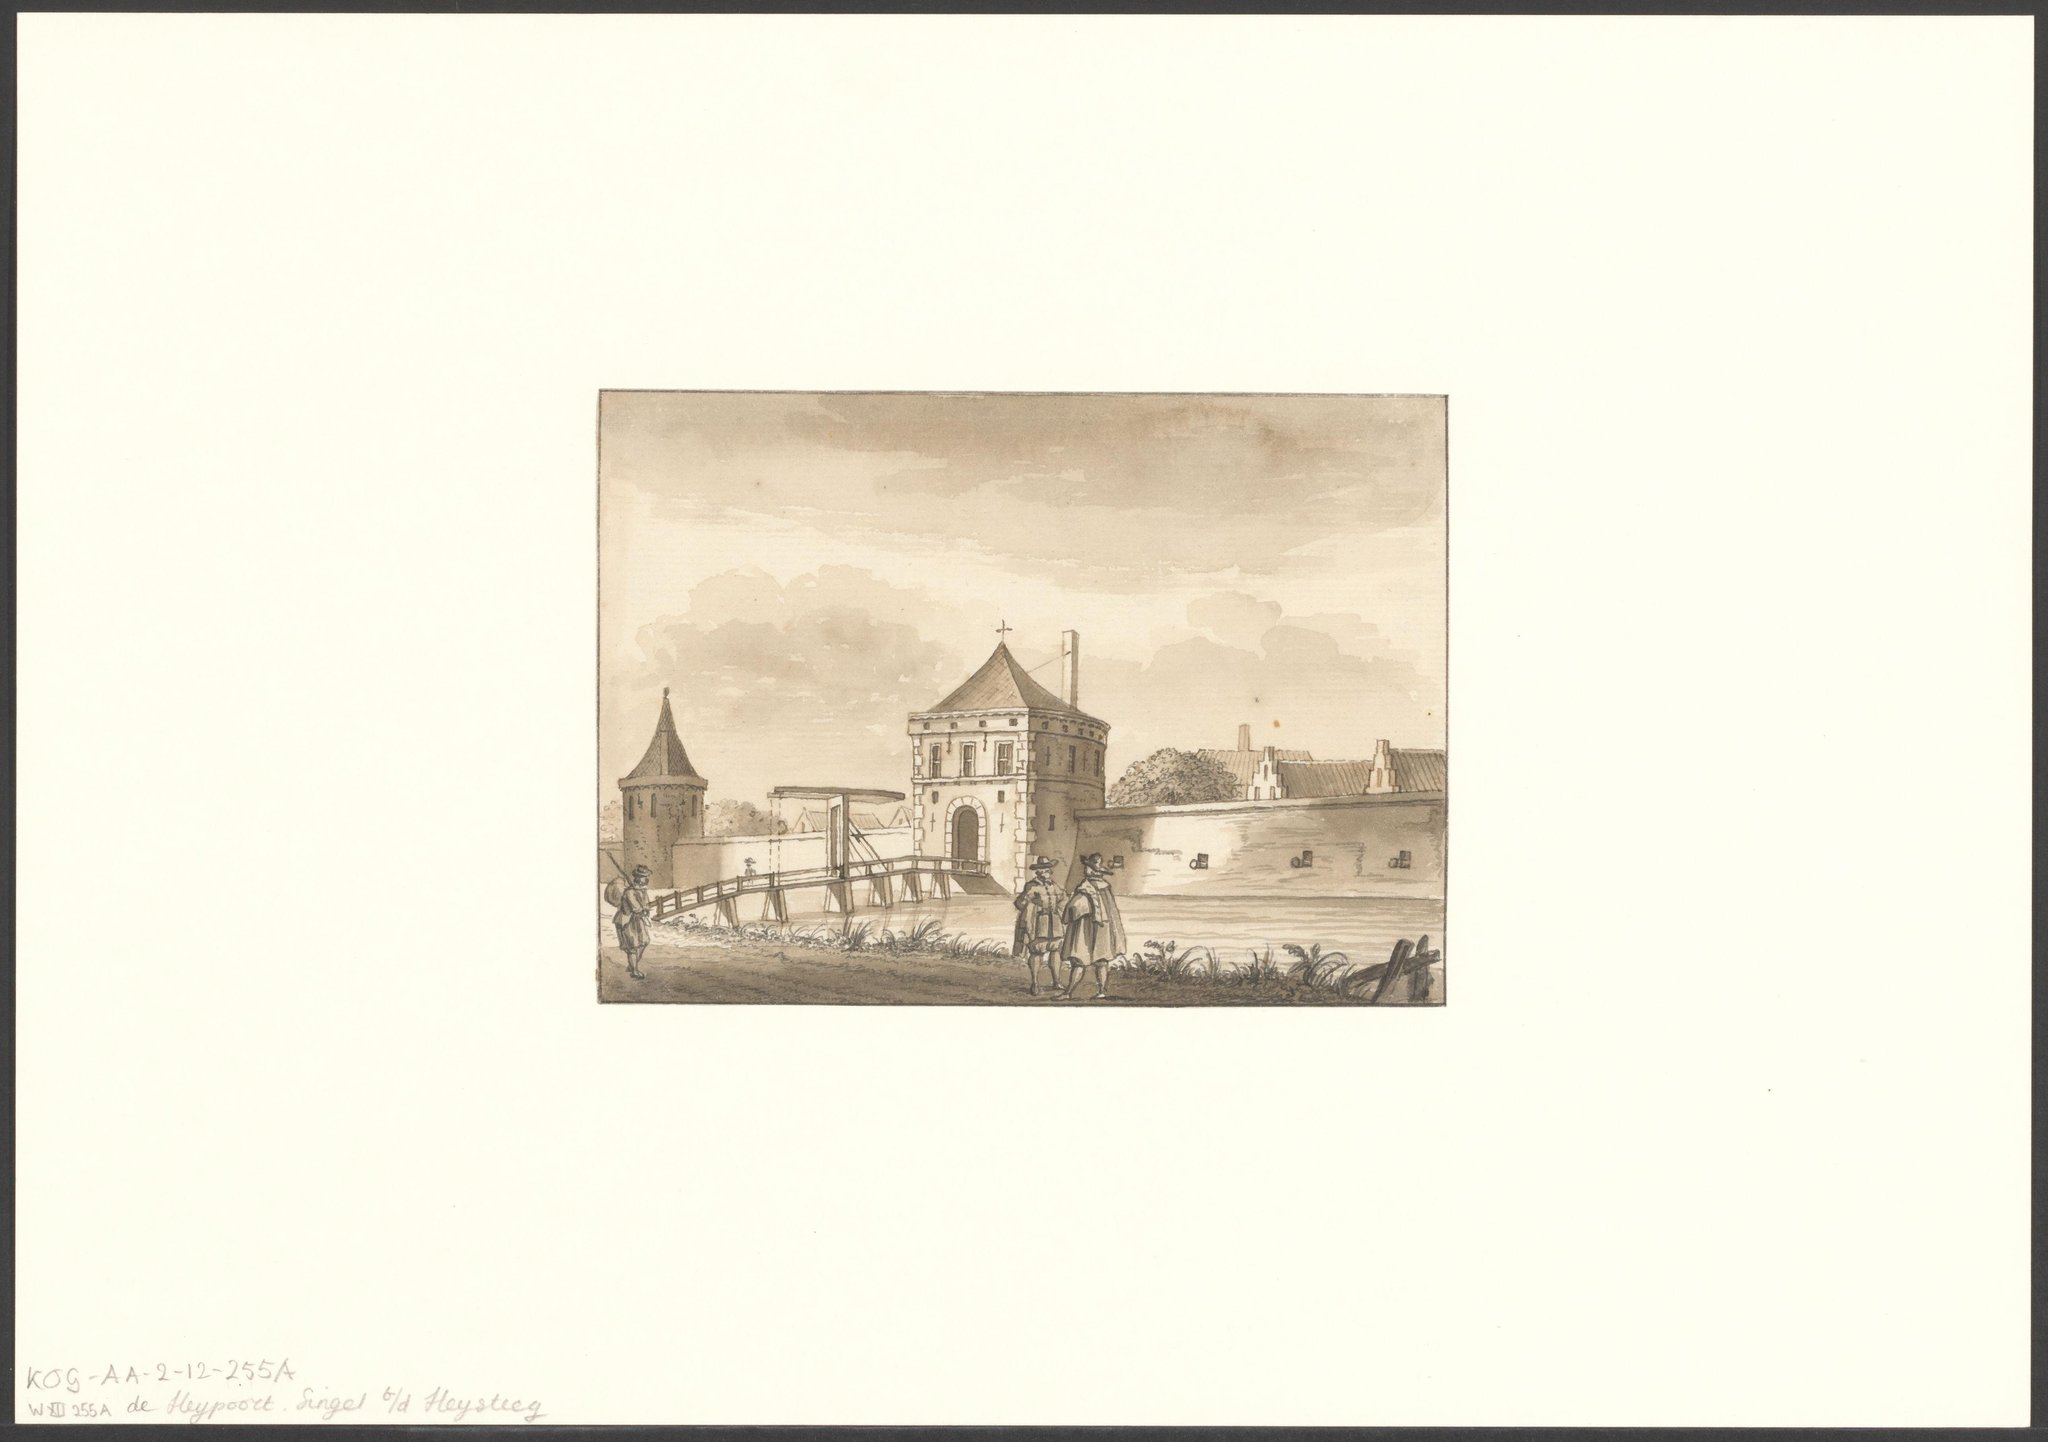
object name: drawing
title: Gezicht op het Singel gezien naar de Heypoort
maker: Anonymous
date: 1700-1799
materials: ink, paper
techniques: brush, pen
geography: amsterdam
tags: city-view, and landscape with man-made constructions, river, bridge in city across river, canal, etc., city-gate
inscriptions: inscription: ‘De Heypoort’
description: Tekening binnen de Atlas Van Eck ingedeeld op wijknummer 12.